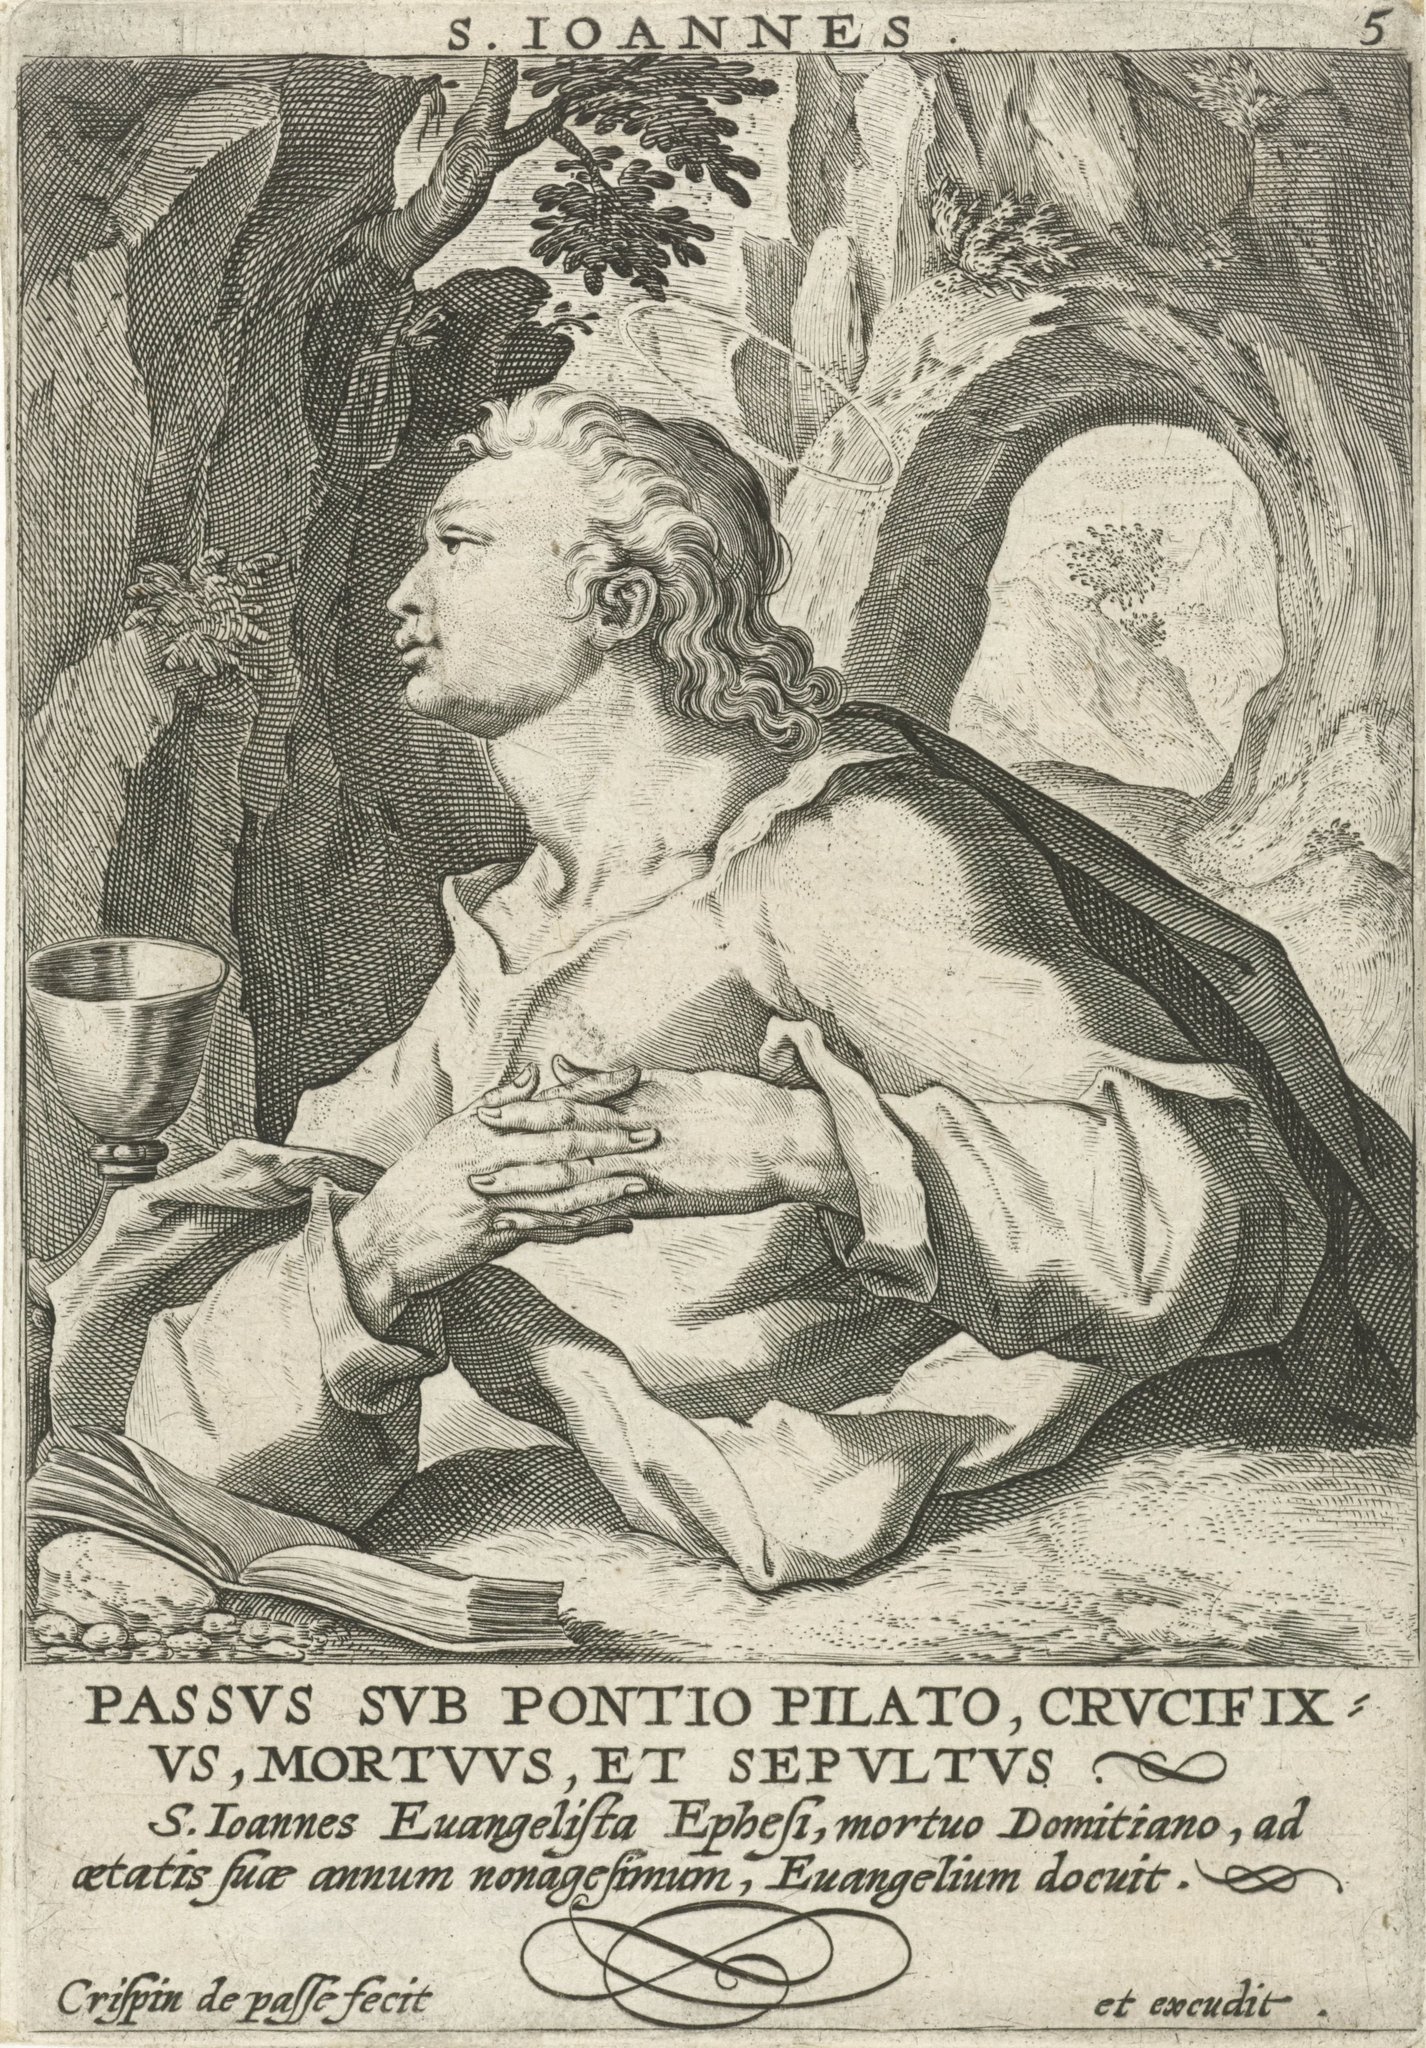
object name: print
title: S. Ioannes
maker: crispijn van de passe (i)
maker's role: draughtsman, print maker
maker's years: 1564-1637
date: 1594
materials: paper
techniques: engraving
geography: cologne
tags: the apostle john the evangelist; possible attributes: book, cauldron, chalice with snake, eagle, palm, scroll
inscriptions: collector's mark: Lugt 2542, collector's mark: Lugt 2228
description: Buste van de apostel Johannes, een opengeslagen boek en een kelk voor hem. Hij zit in een grot. In de marge een onderschrift in het Latijn. Prent uit een serie met Christus en de apostelen.